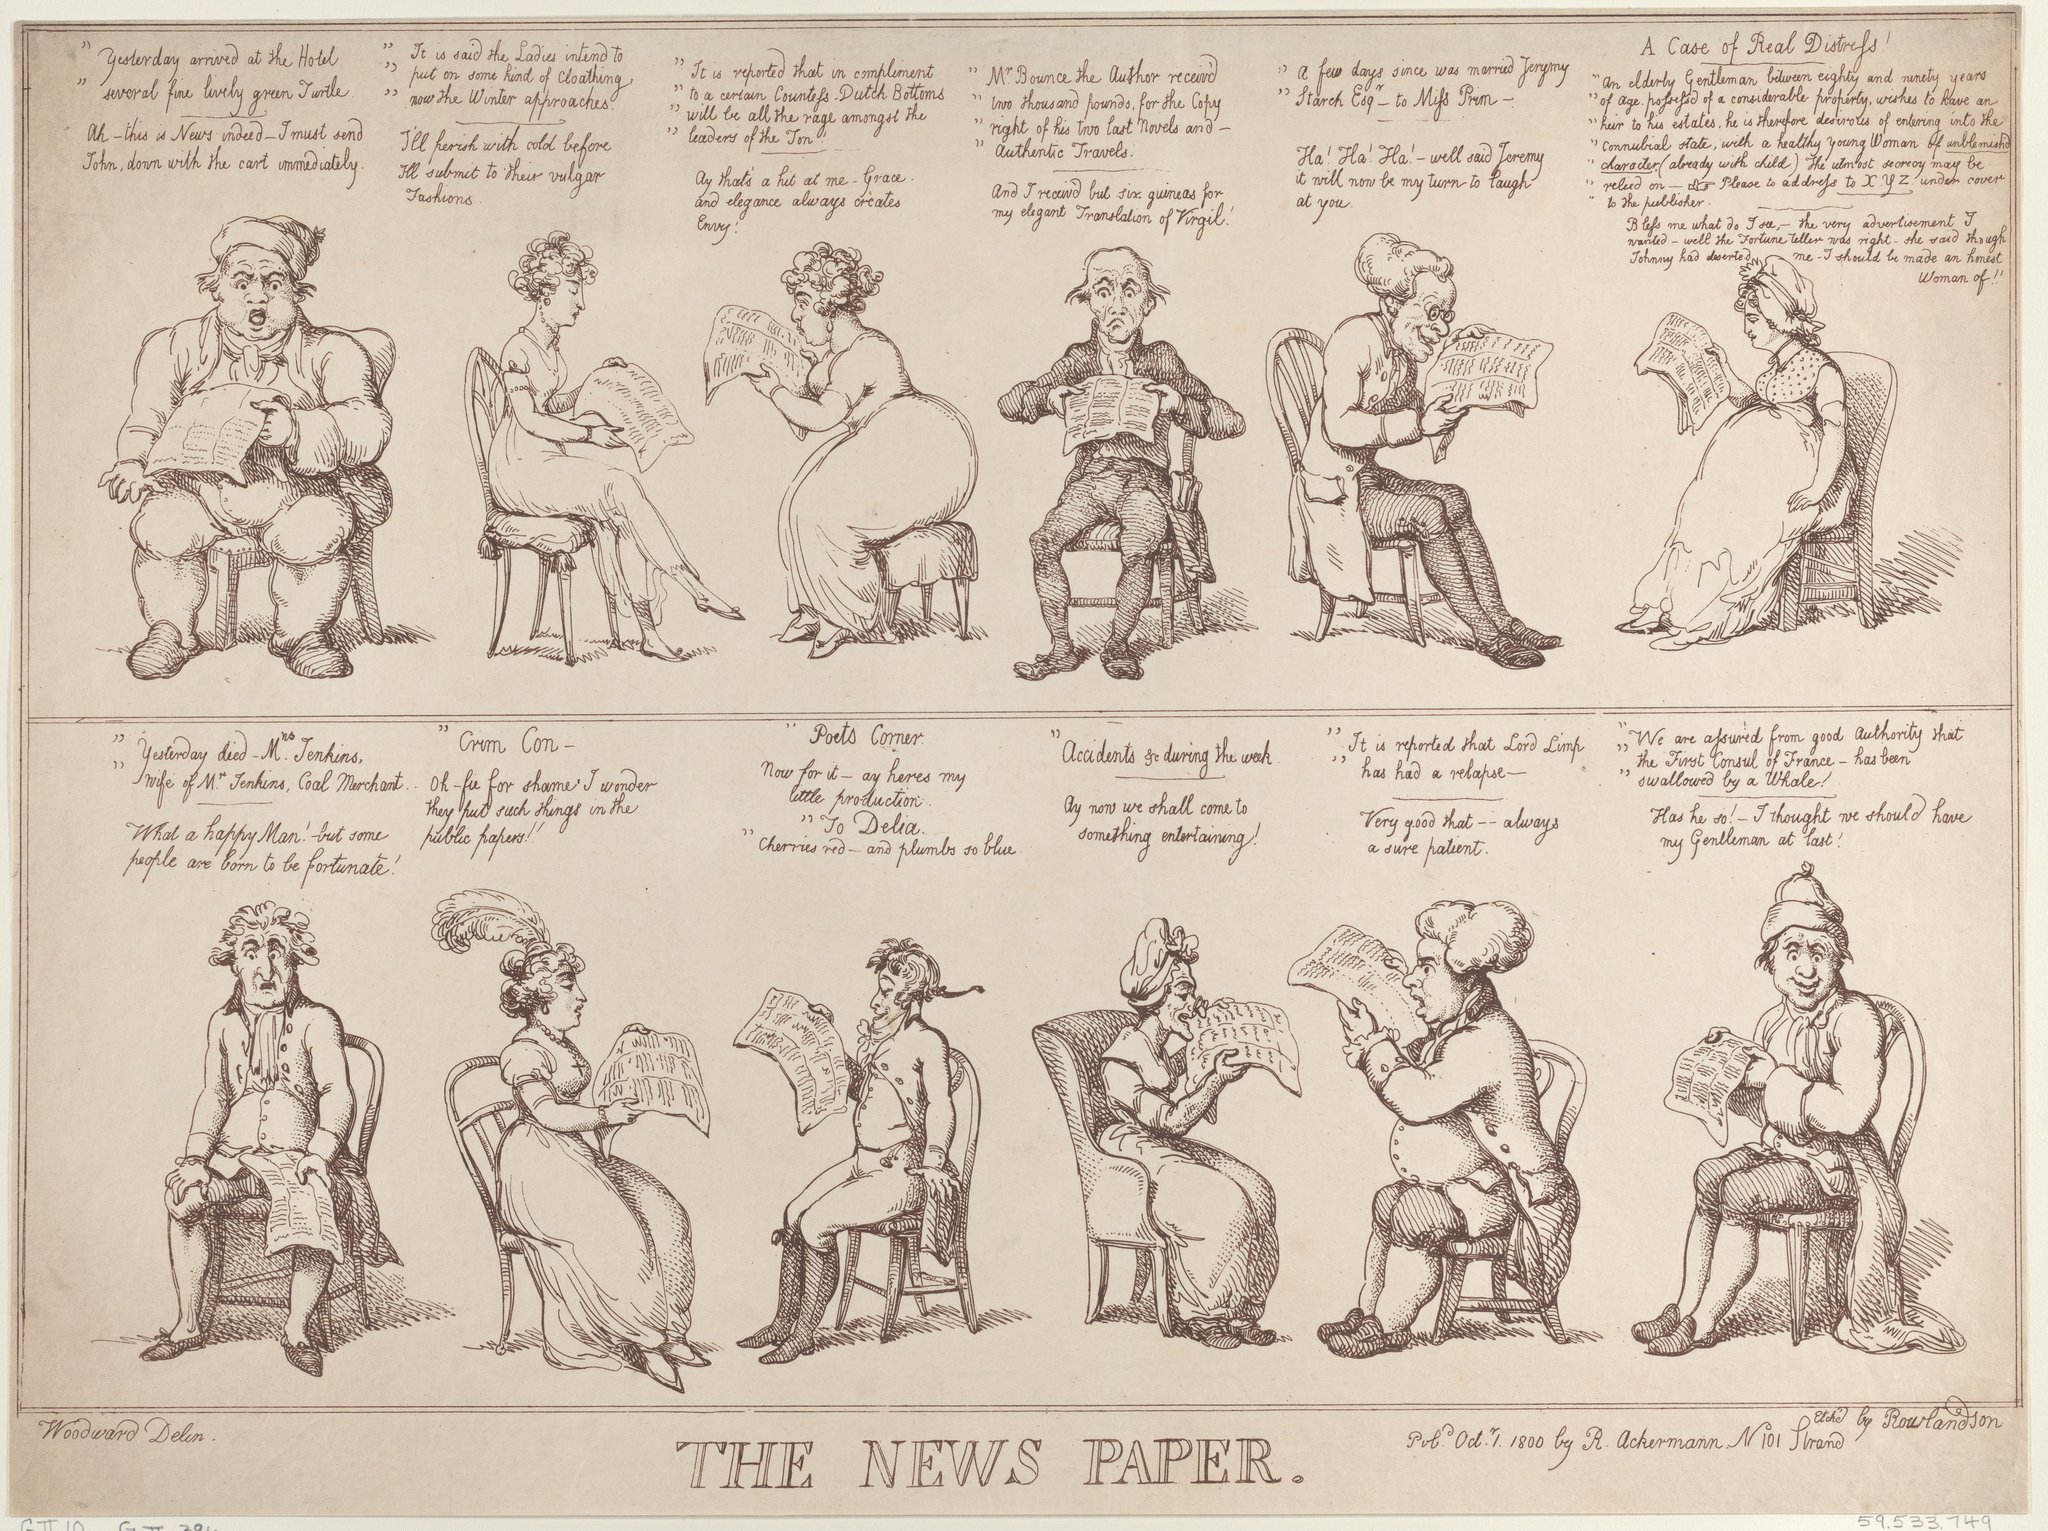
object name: print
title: The News Paper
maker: thomas rowlandson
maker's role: artist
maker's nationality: british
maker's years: 1757-1827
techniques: etching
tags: satire,men,women,reading,newspapers